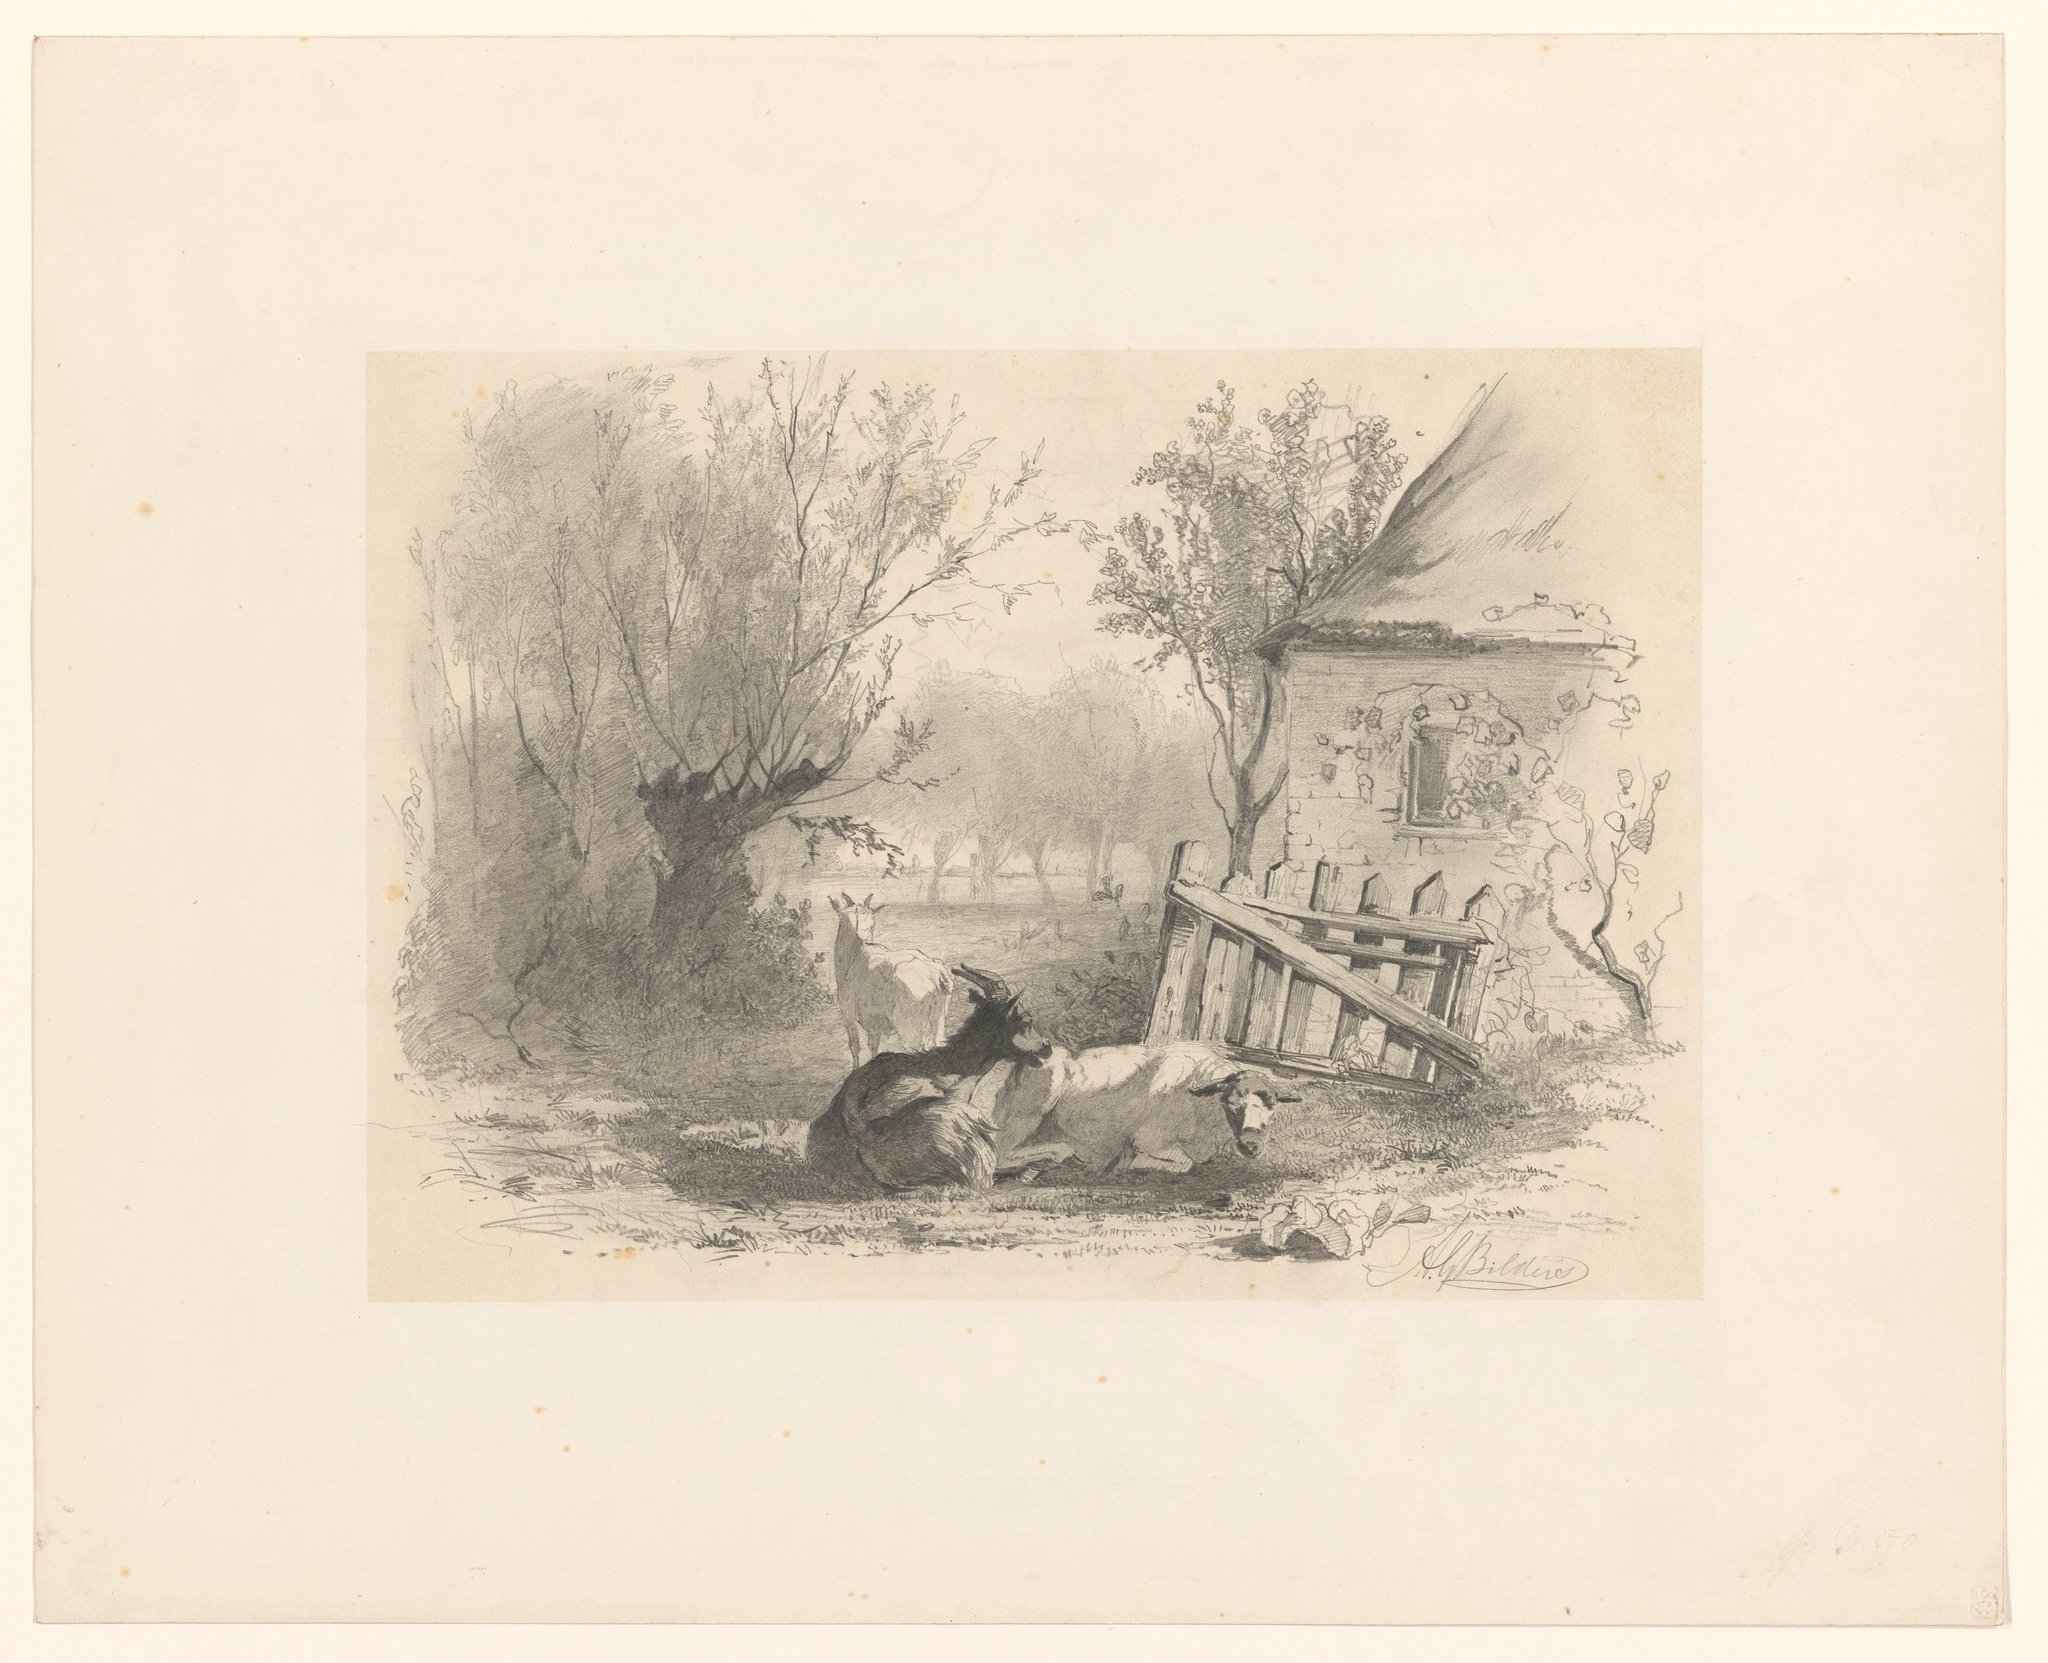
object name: drawing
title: Twee geiten en een schaap bij een hek voor een huis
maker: gerard bilders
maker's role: draughtsman, print maker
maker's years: 1838-1865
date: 1848-1865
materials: paper, pencil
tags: sheep